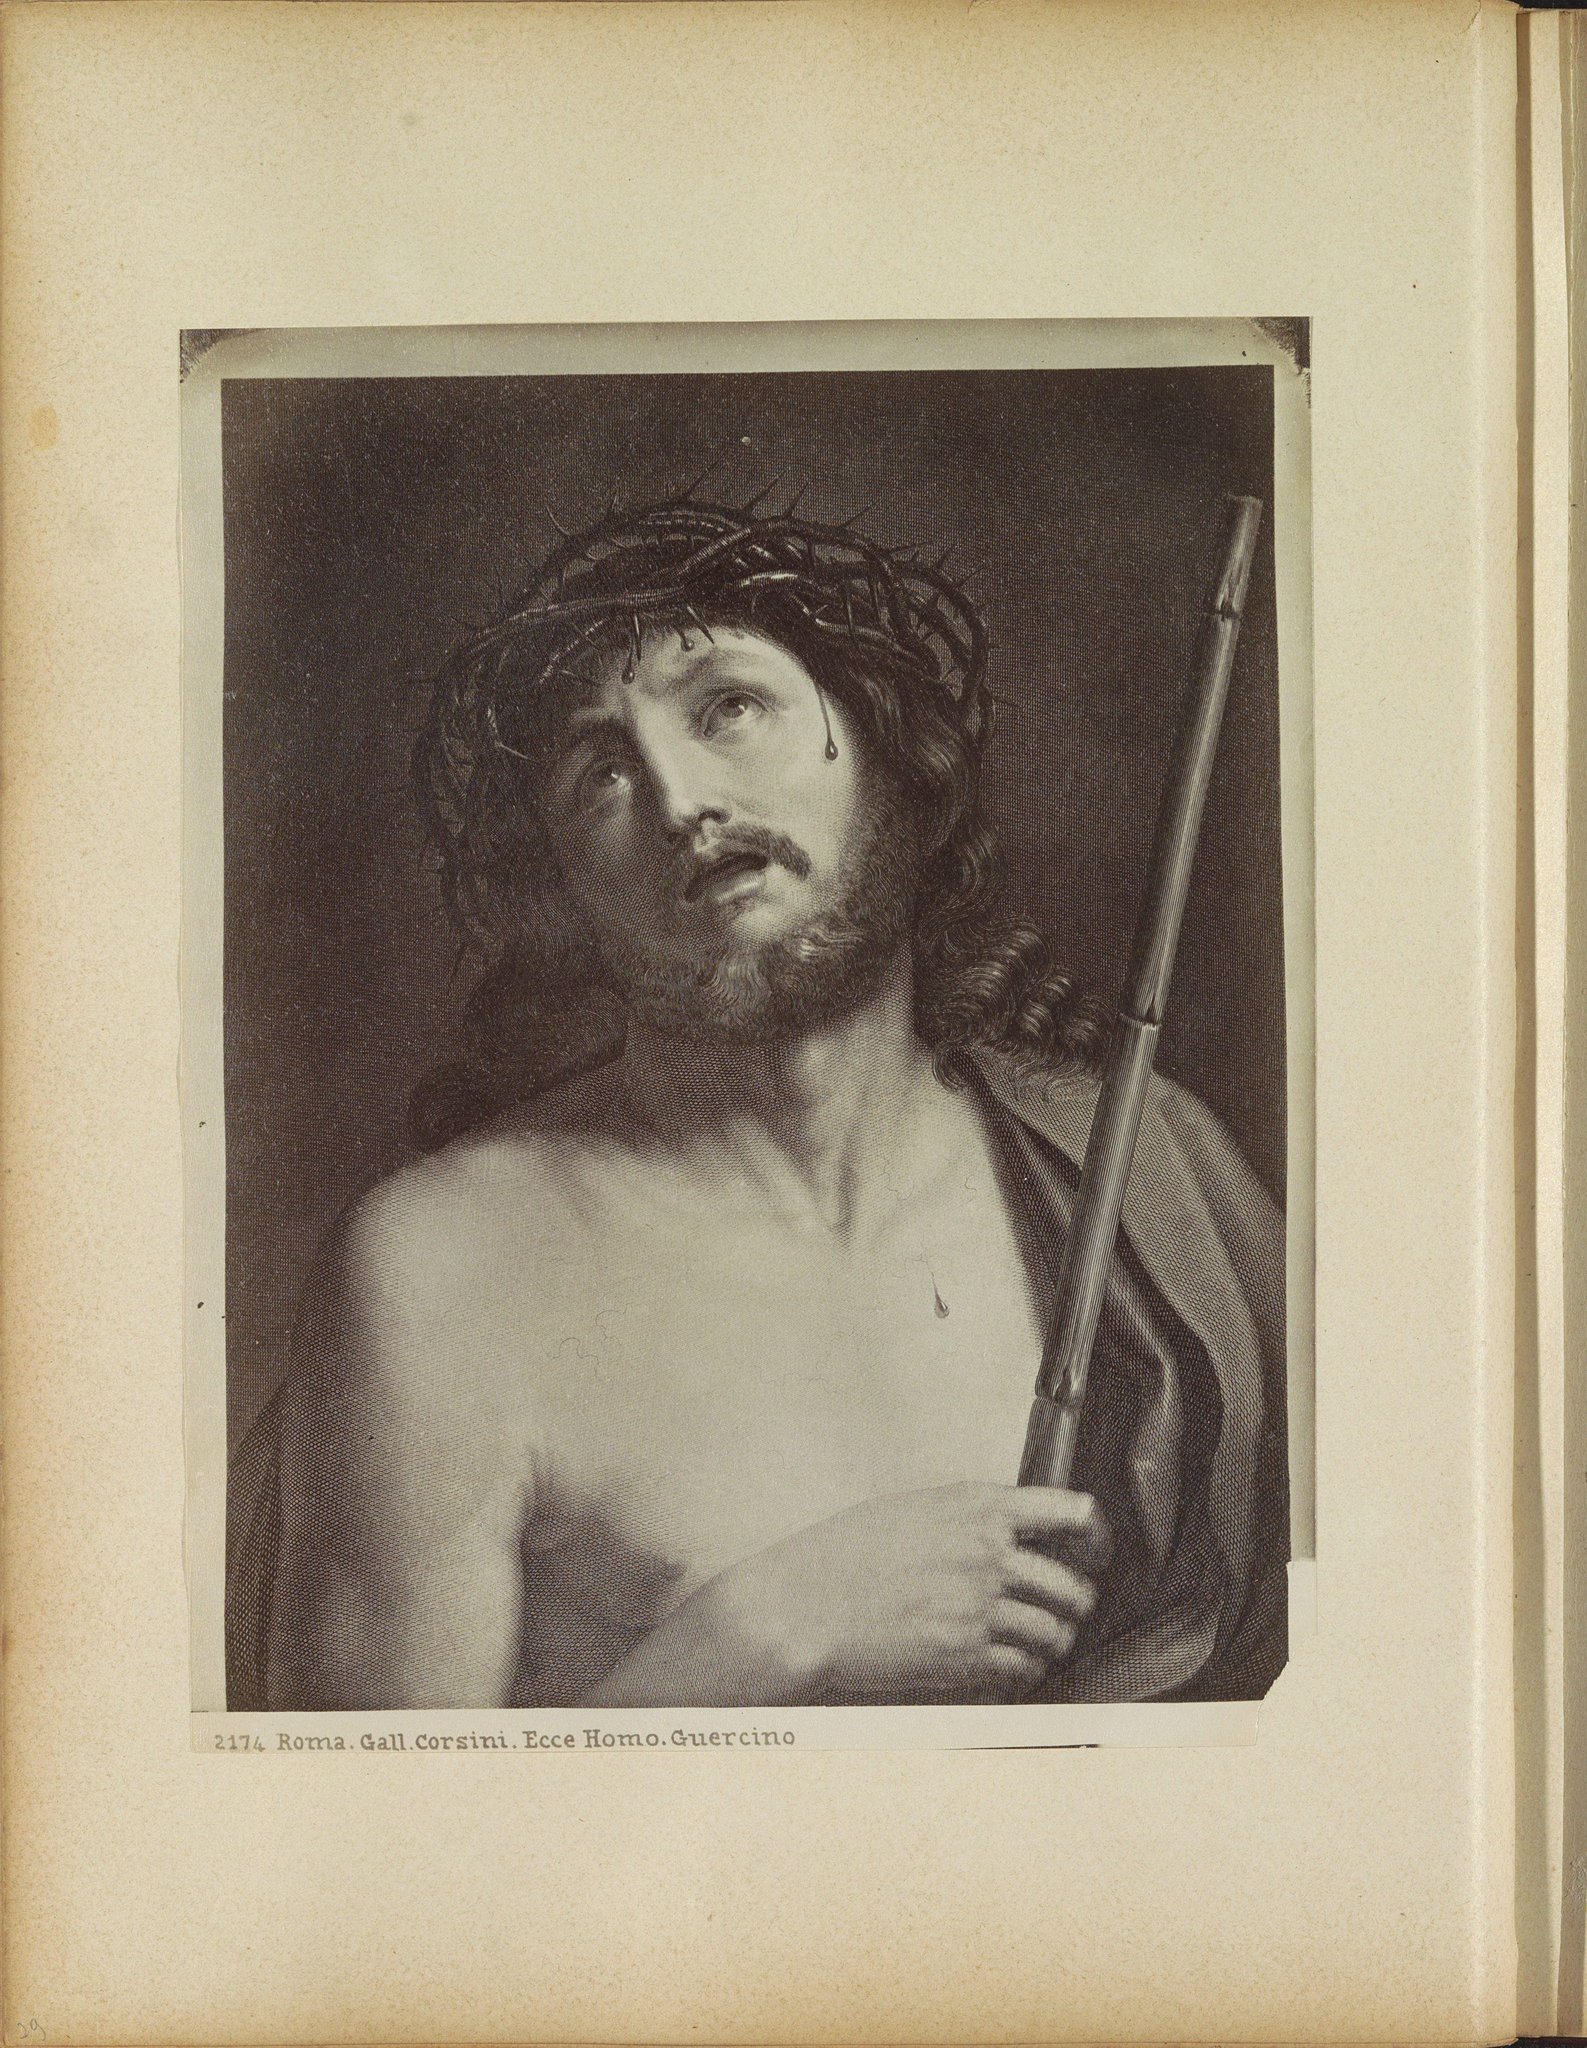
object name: photograph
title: Roma. Gall. Corsini. Ecce Homo. Guercino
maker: Anonymous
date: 1860-1900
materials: photographic support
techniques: albumen print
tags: head of christ with crown of thorns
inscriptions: number: ‘2174’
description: Onderdeel van Fotoalbum met opnames van bezienswaardigheden in Italiaanse steden en van kunstwerken.